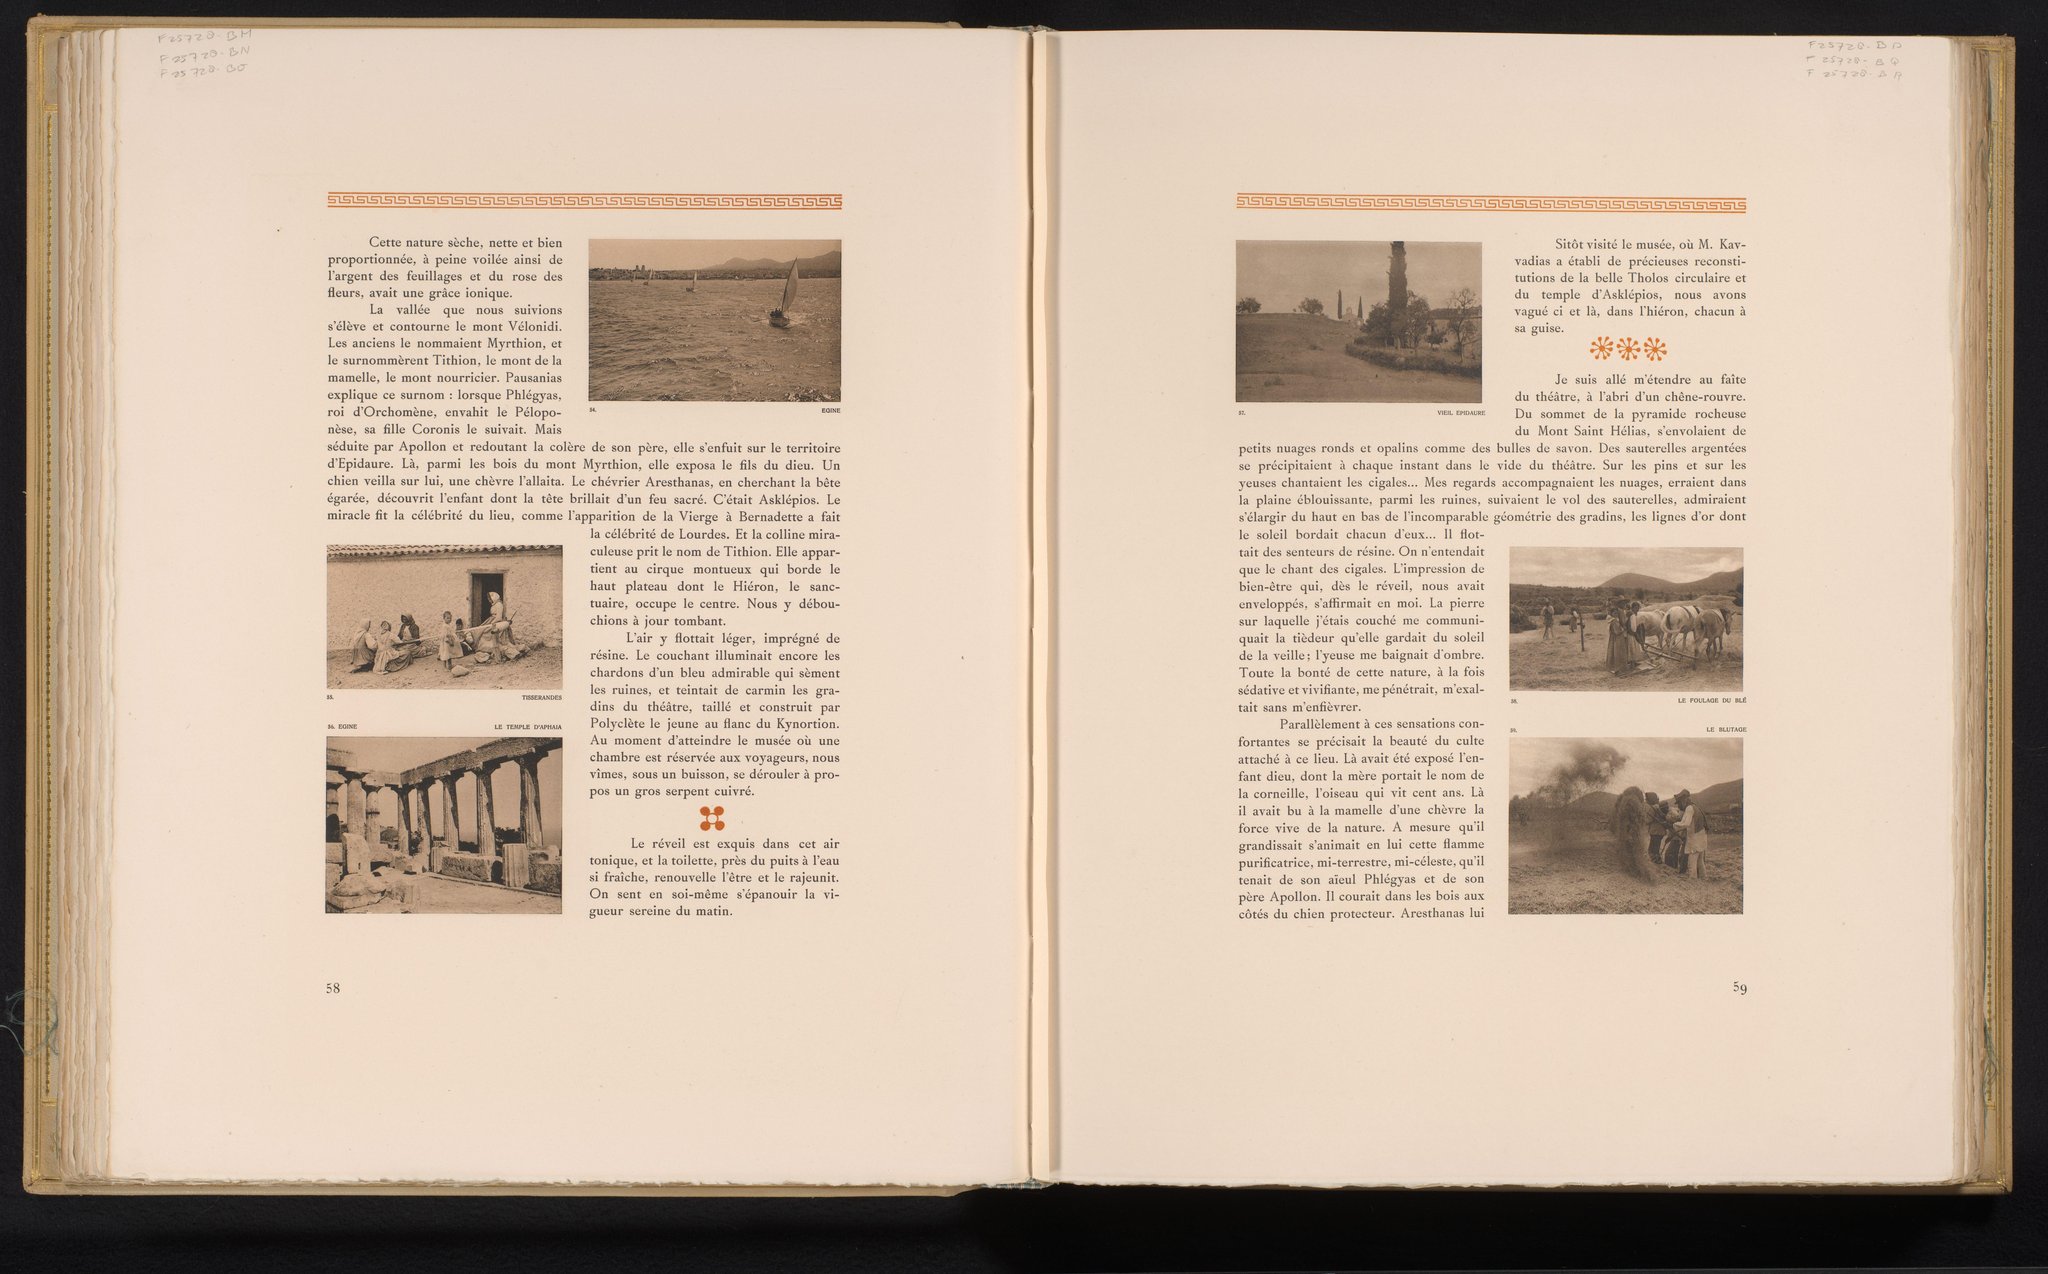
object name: page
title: Gezicht op Epidaurus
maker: frédéric boissonnas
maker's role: fotograaf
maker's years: 1858-1946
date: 1905-1910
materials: paper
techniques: photograph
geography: berlin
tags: city-view, and landscape with man-made constructions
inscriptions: number: ‘57.’